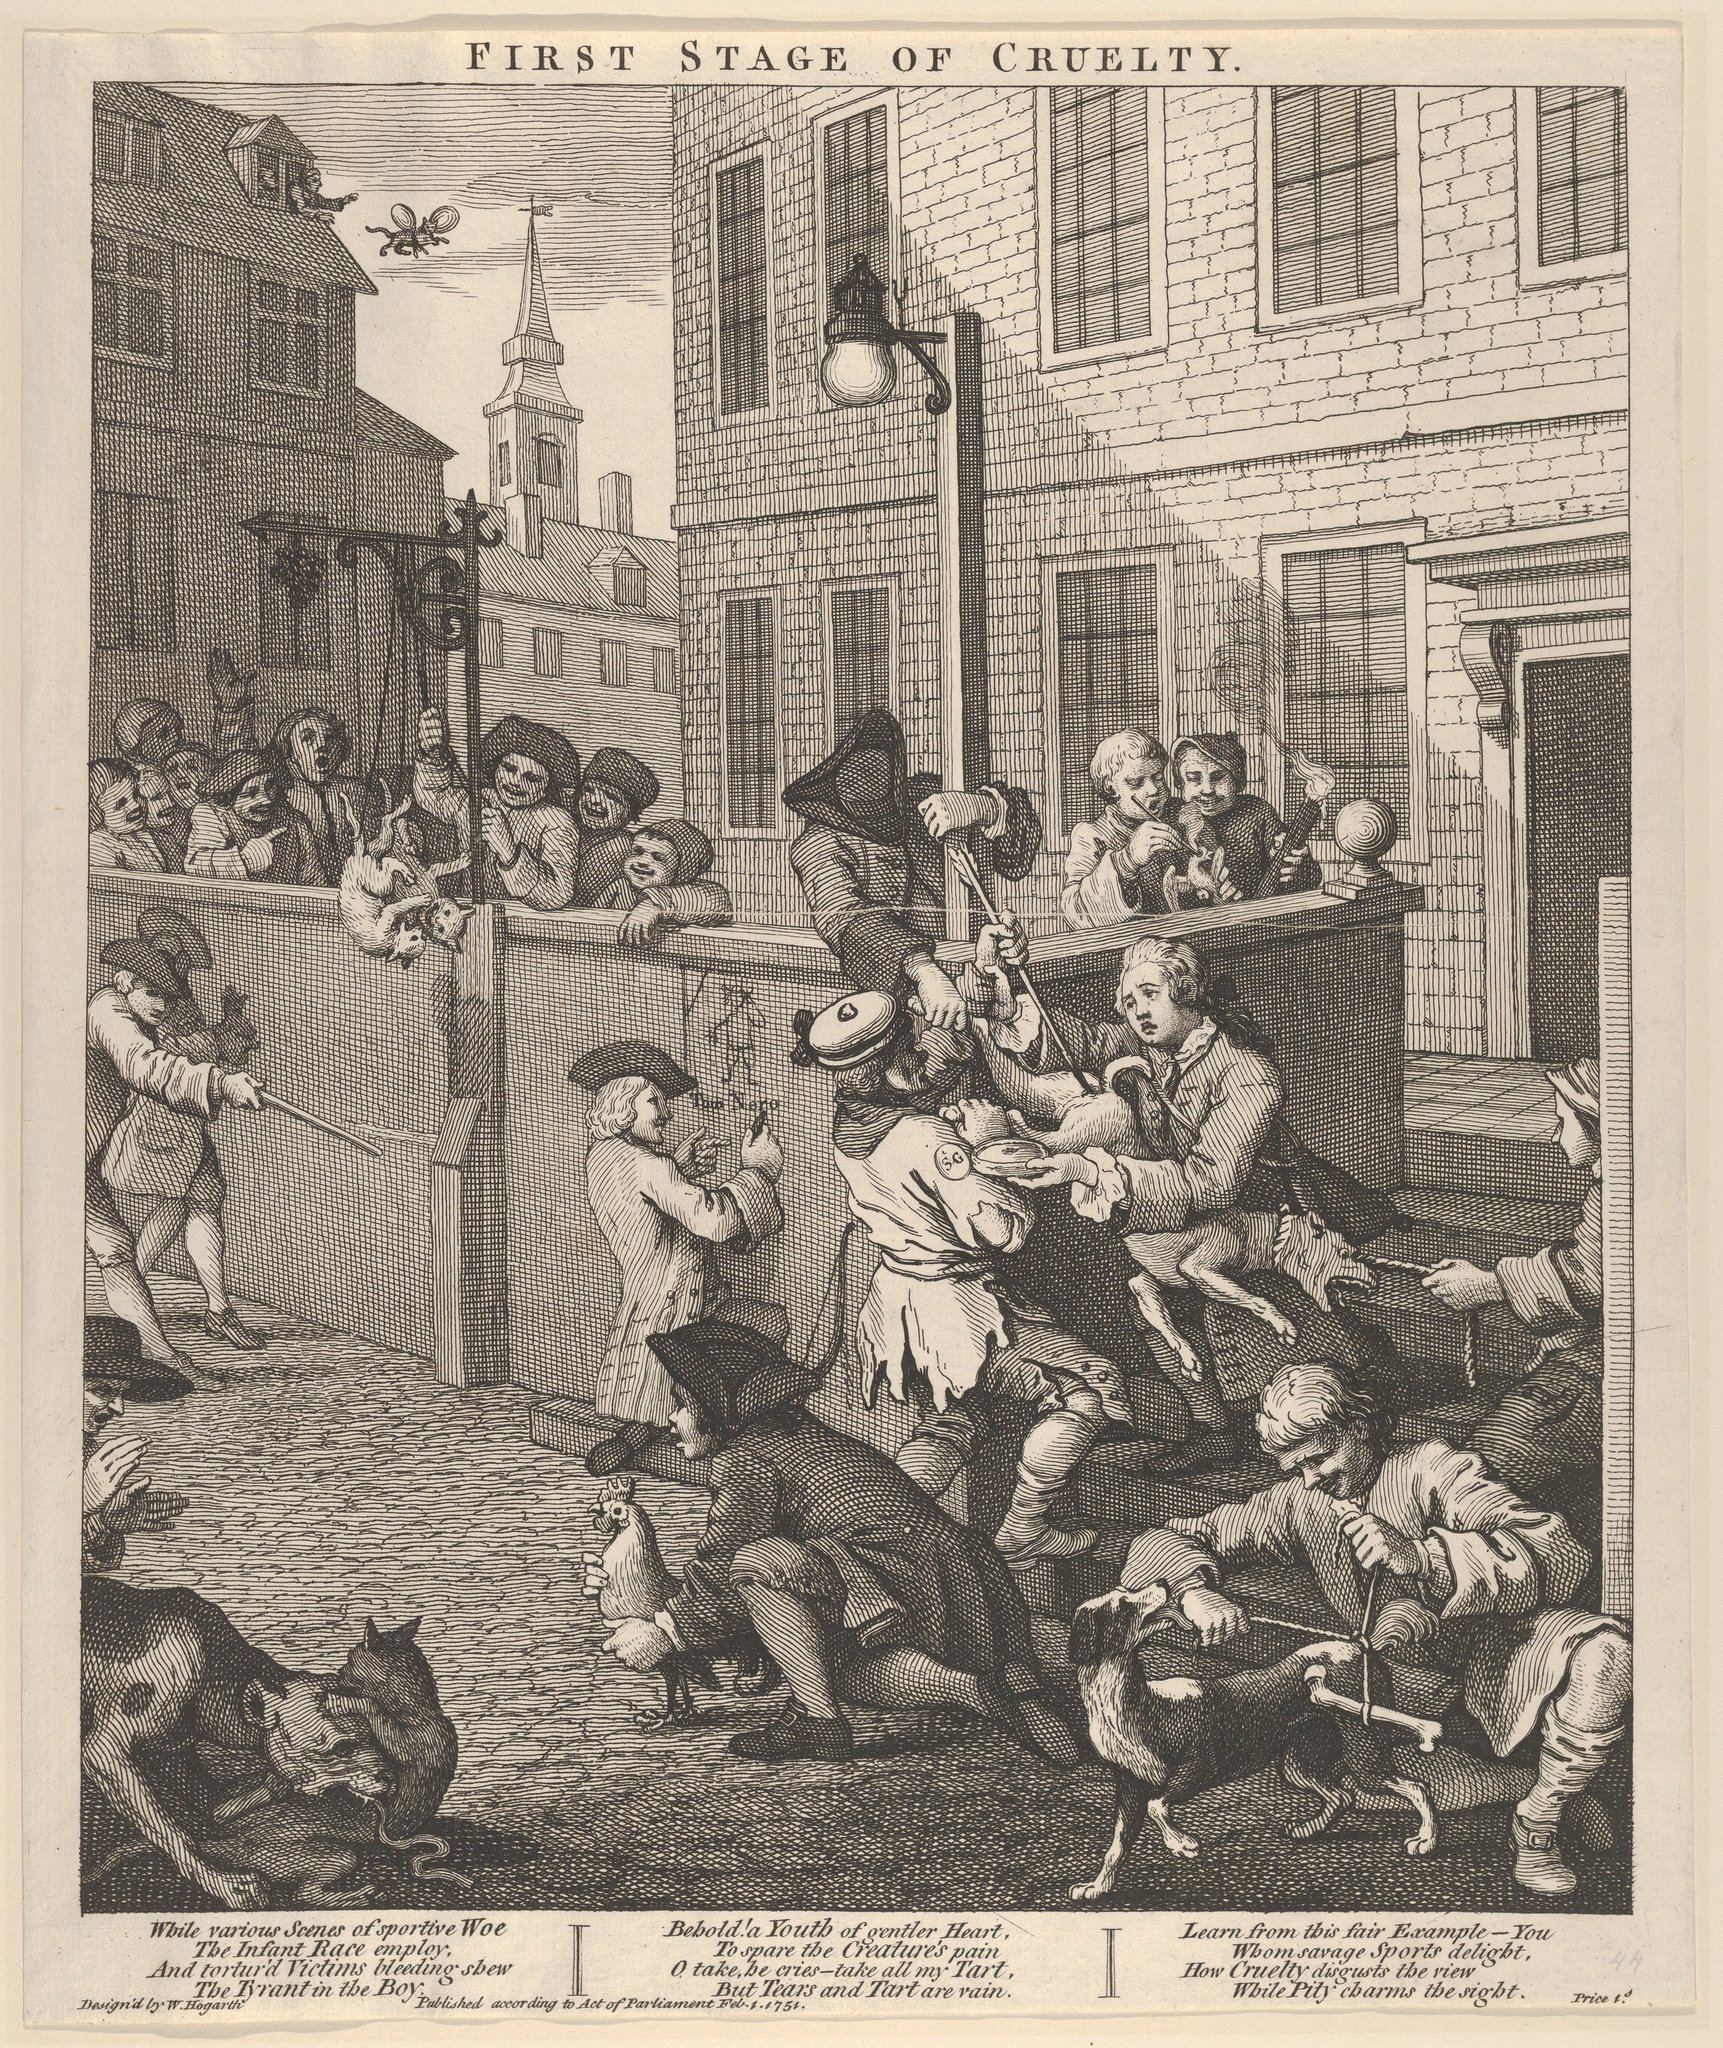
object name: print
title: The First Stage of Cruelty (The Four Stages of Cruelty)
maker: william hogarth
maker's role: artist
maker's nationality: british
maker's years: 1697-1764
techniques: engraving, etching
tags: men,dogs